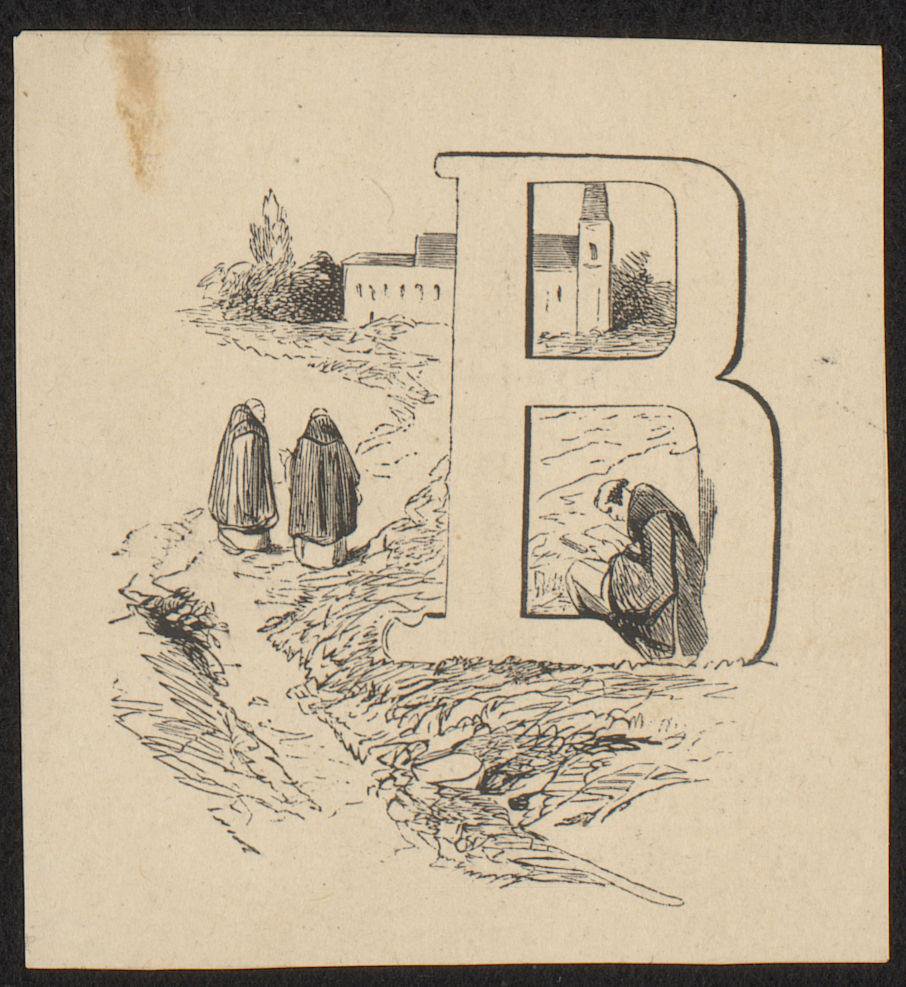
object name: print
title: Initiaal B met klooster en monniken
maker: isaac weissenbruch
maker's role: print maker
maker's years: 1826-1912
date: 1836-1912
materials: paper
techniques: engraving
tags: initial, fancy letters